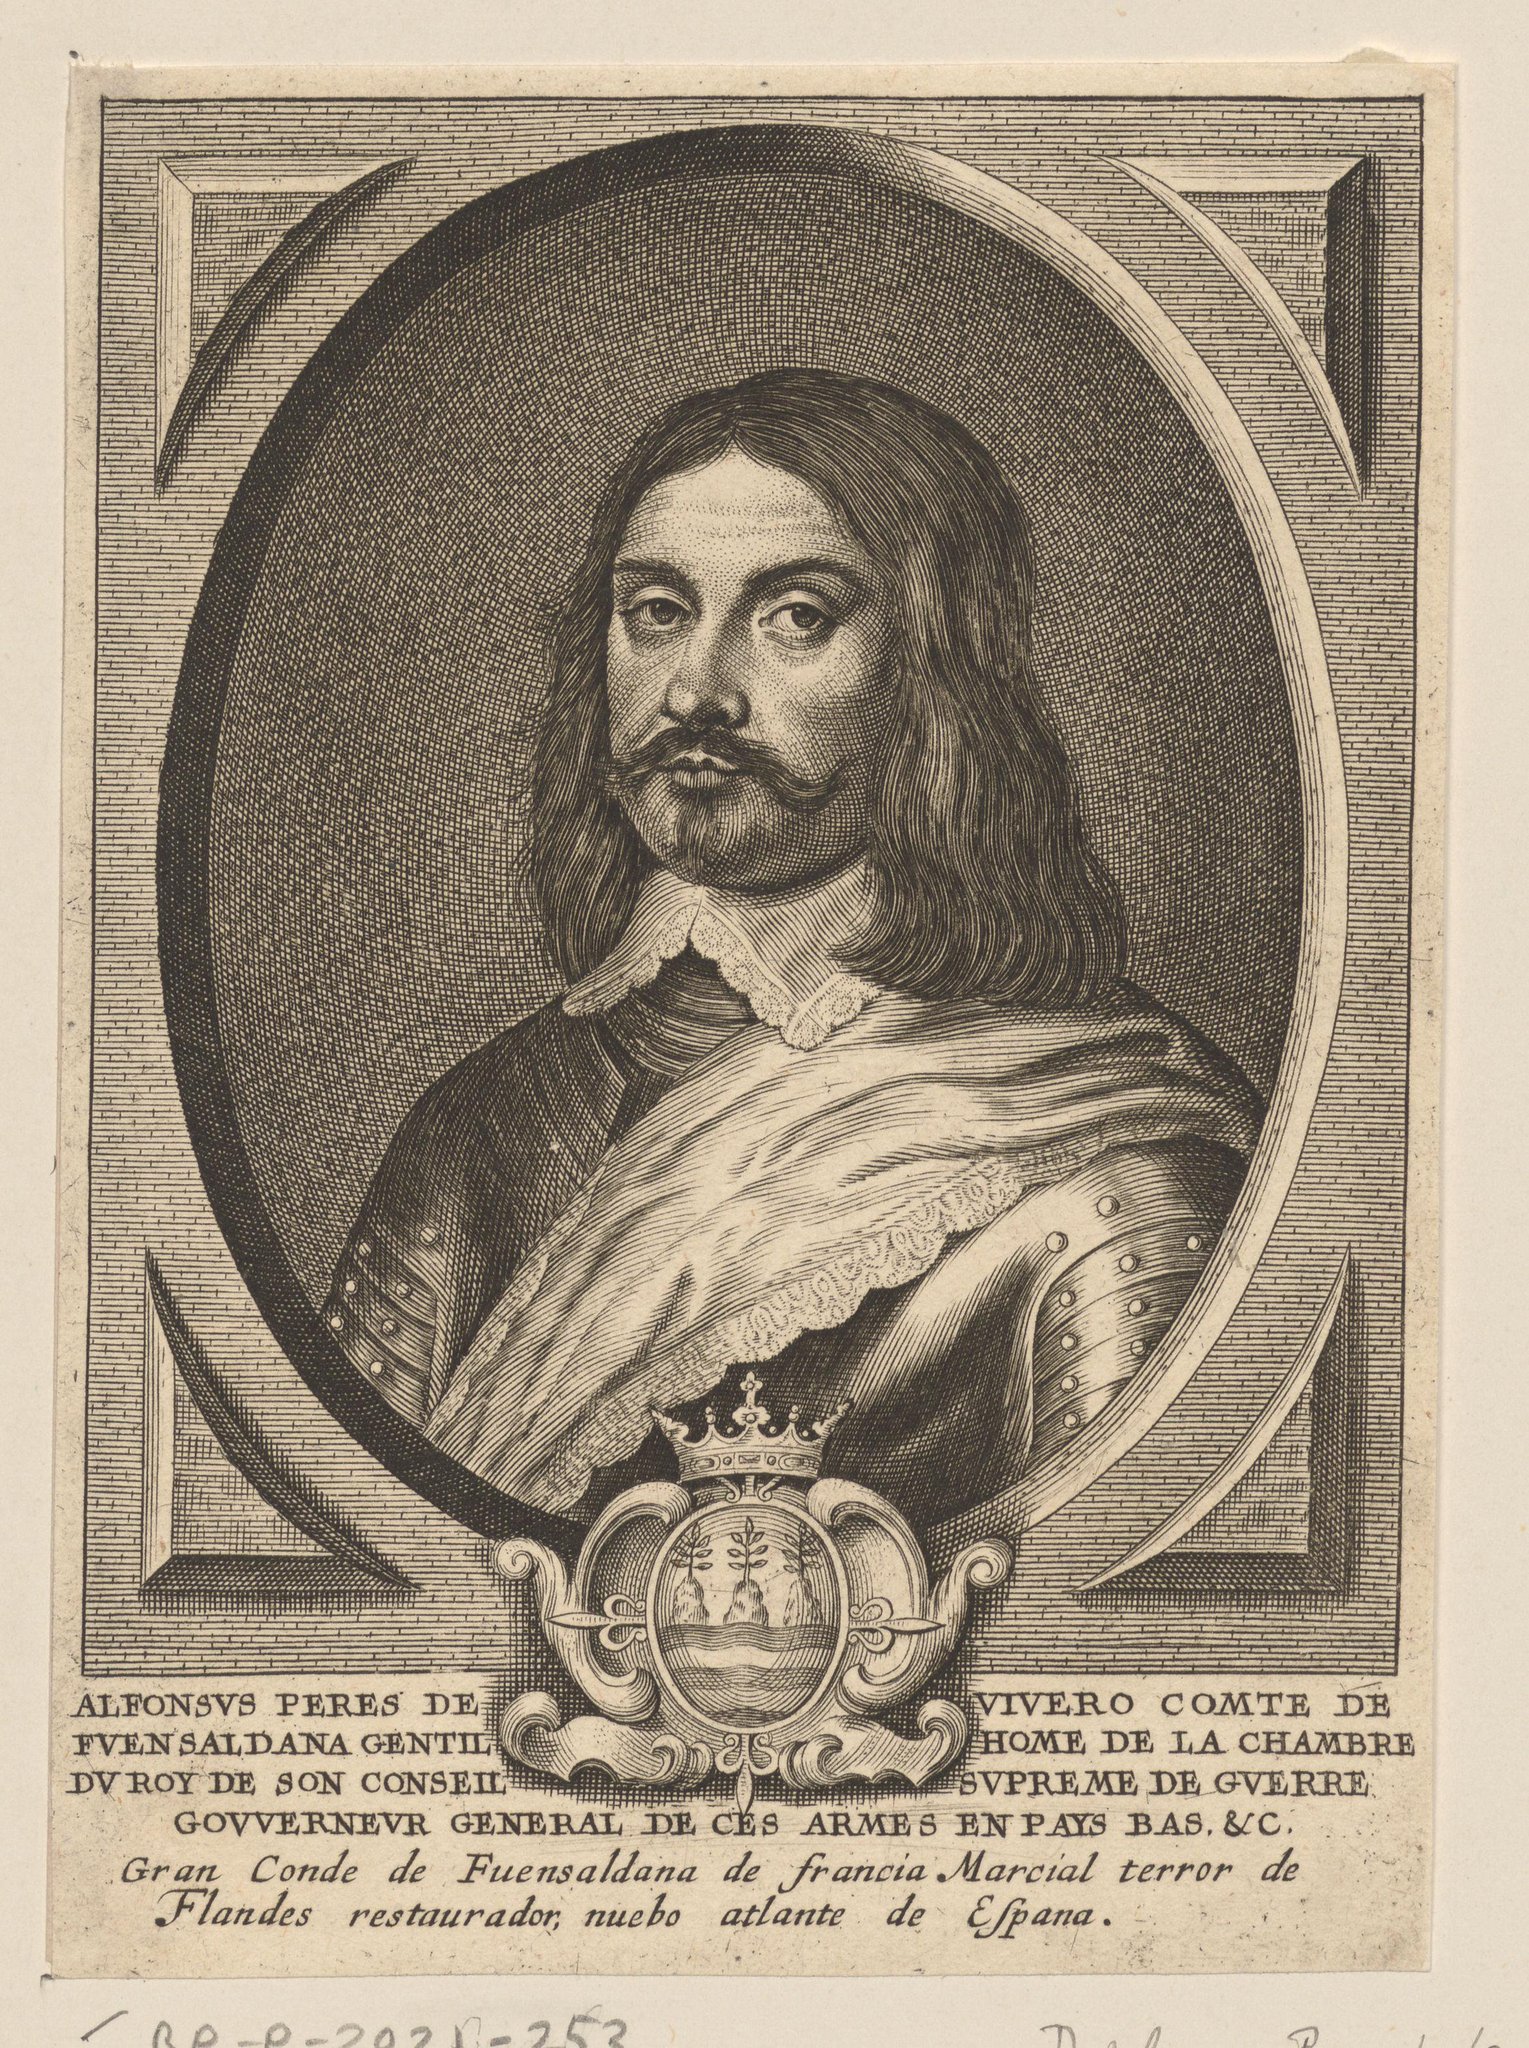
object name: print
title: Portret van Alfonso Pérez de Vivero, graaf van Fuensaldaña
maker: Anonymous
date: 1640-1700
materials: paper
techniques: engraving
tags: alonso pérez de vivero y menchaca (graaf van fuensaldaña), historical persons, armorial bearing, heraldry